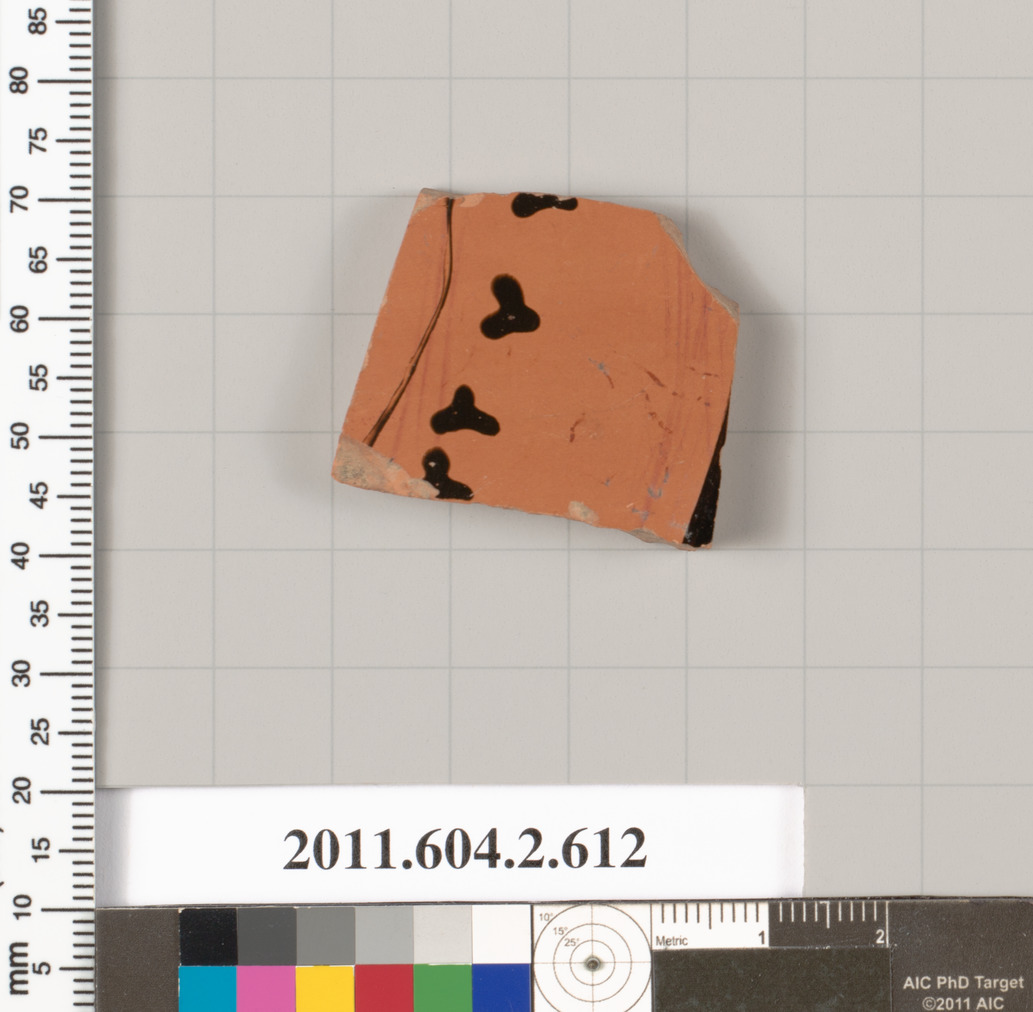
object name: column krater fragment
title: Terracotta fragment of a column-krater (bowl for mixing wine and water)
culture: greek, attic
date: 460-440 BCE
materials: terracotta